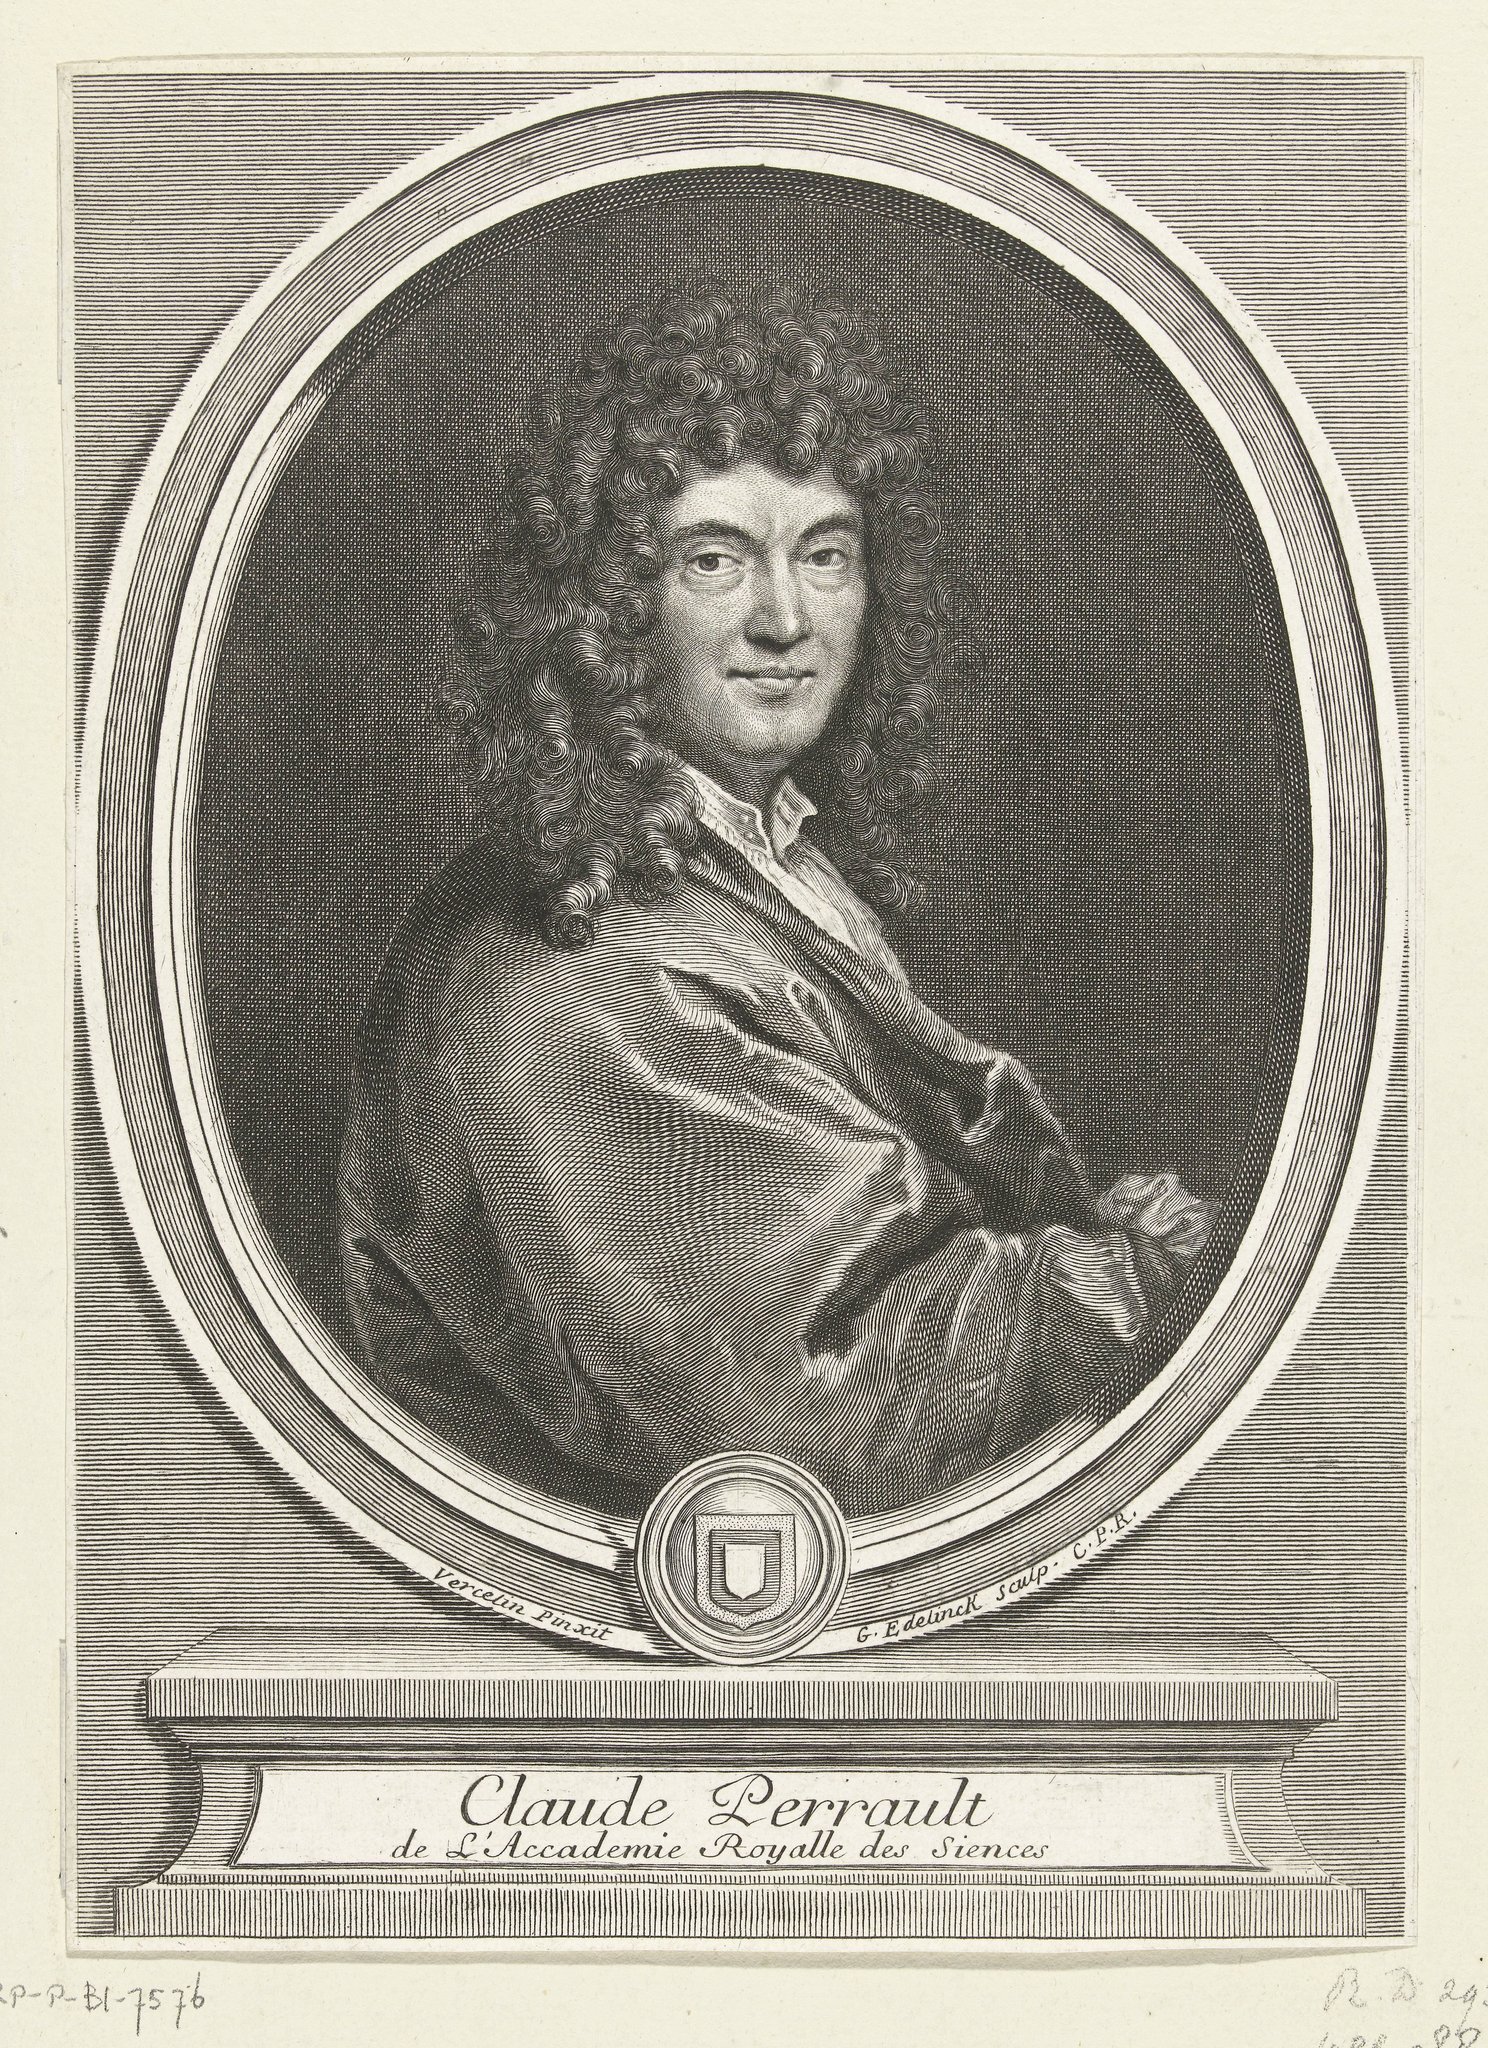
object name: print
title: Portret van Claude Perrault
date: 1666-1707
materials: paper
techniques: engraving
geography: france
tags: paris, print maker, claude perrault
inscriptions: collector's mark: Lugt 240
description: Portret van de Franse architect en medicus Claude Perrault (1613-1688), afgebeeld in ovale omlijsting met wapen. Onder de lijst een console waarop zijn naam.